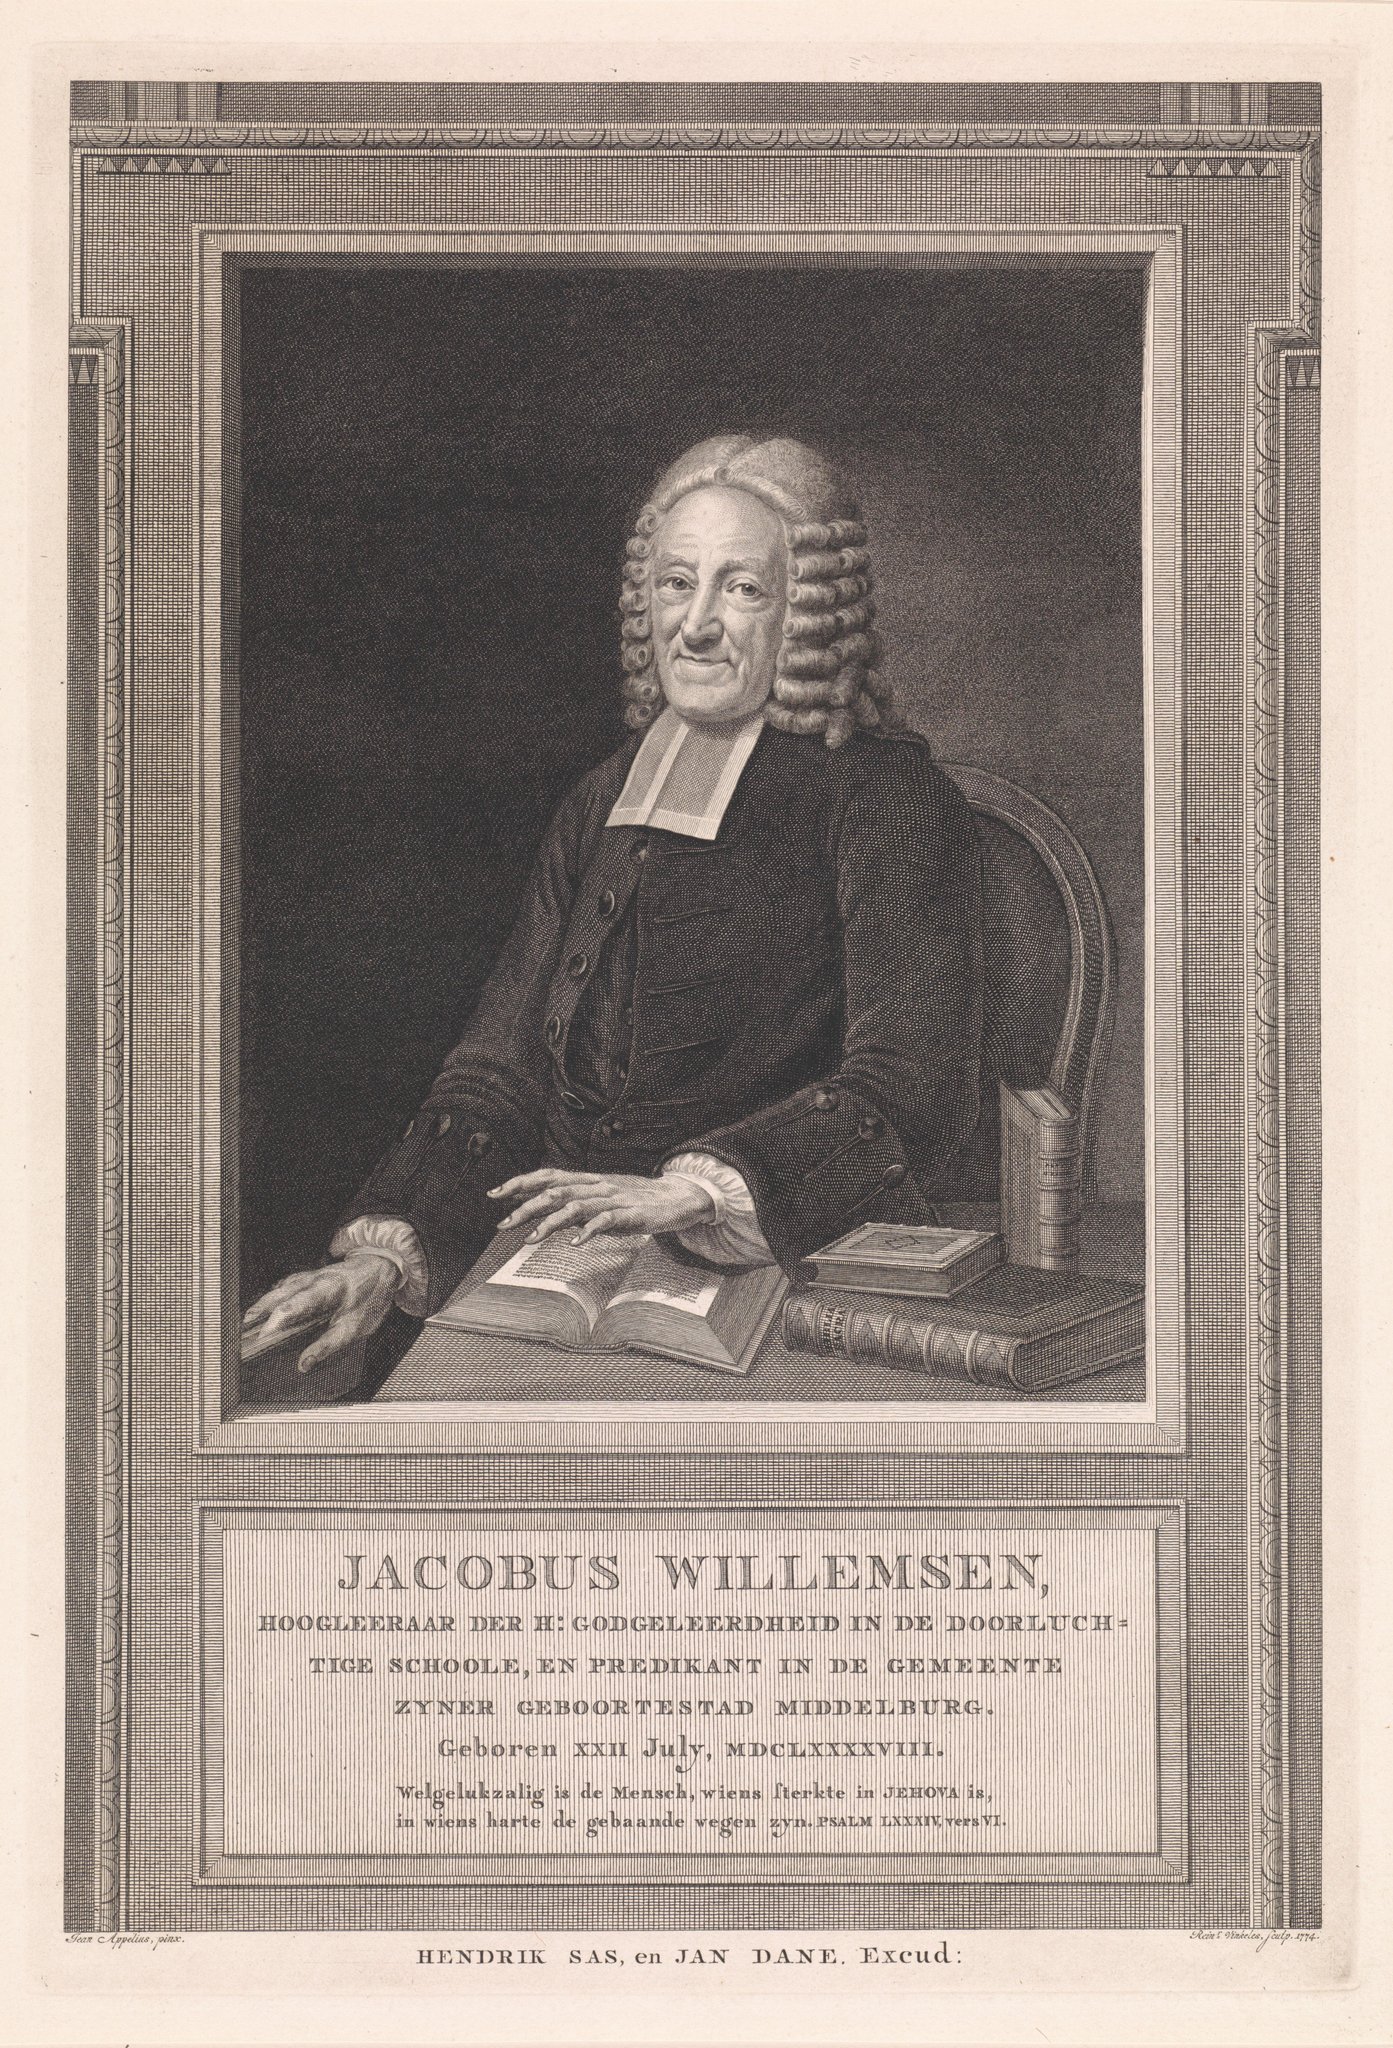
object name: print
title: Portret van Jacobus Willemsen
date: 1774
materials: paper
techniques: engraving, etching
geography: middelburg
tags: middelburg, book - mm - book open, book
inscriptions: collector's mark: Lugt 2228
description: Portret van Jacobus Willemsen, hoogleraar in de theologie en predikant te Middelburg. Voor hem een tafel waarop enkele boeken.